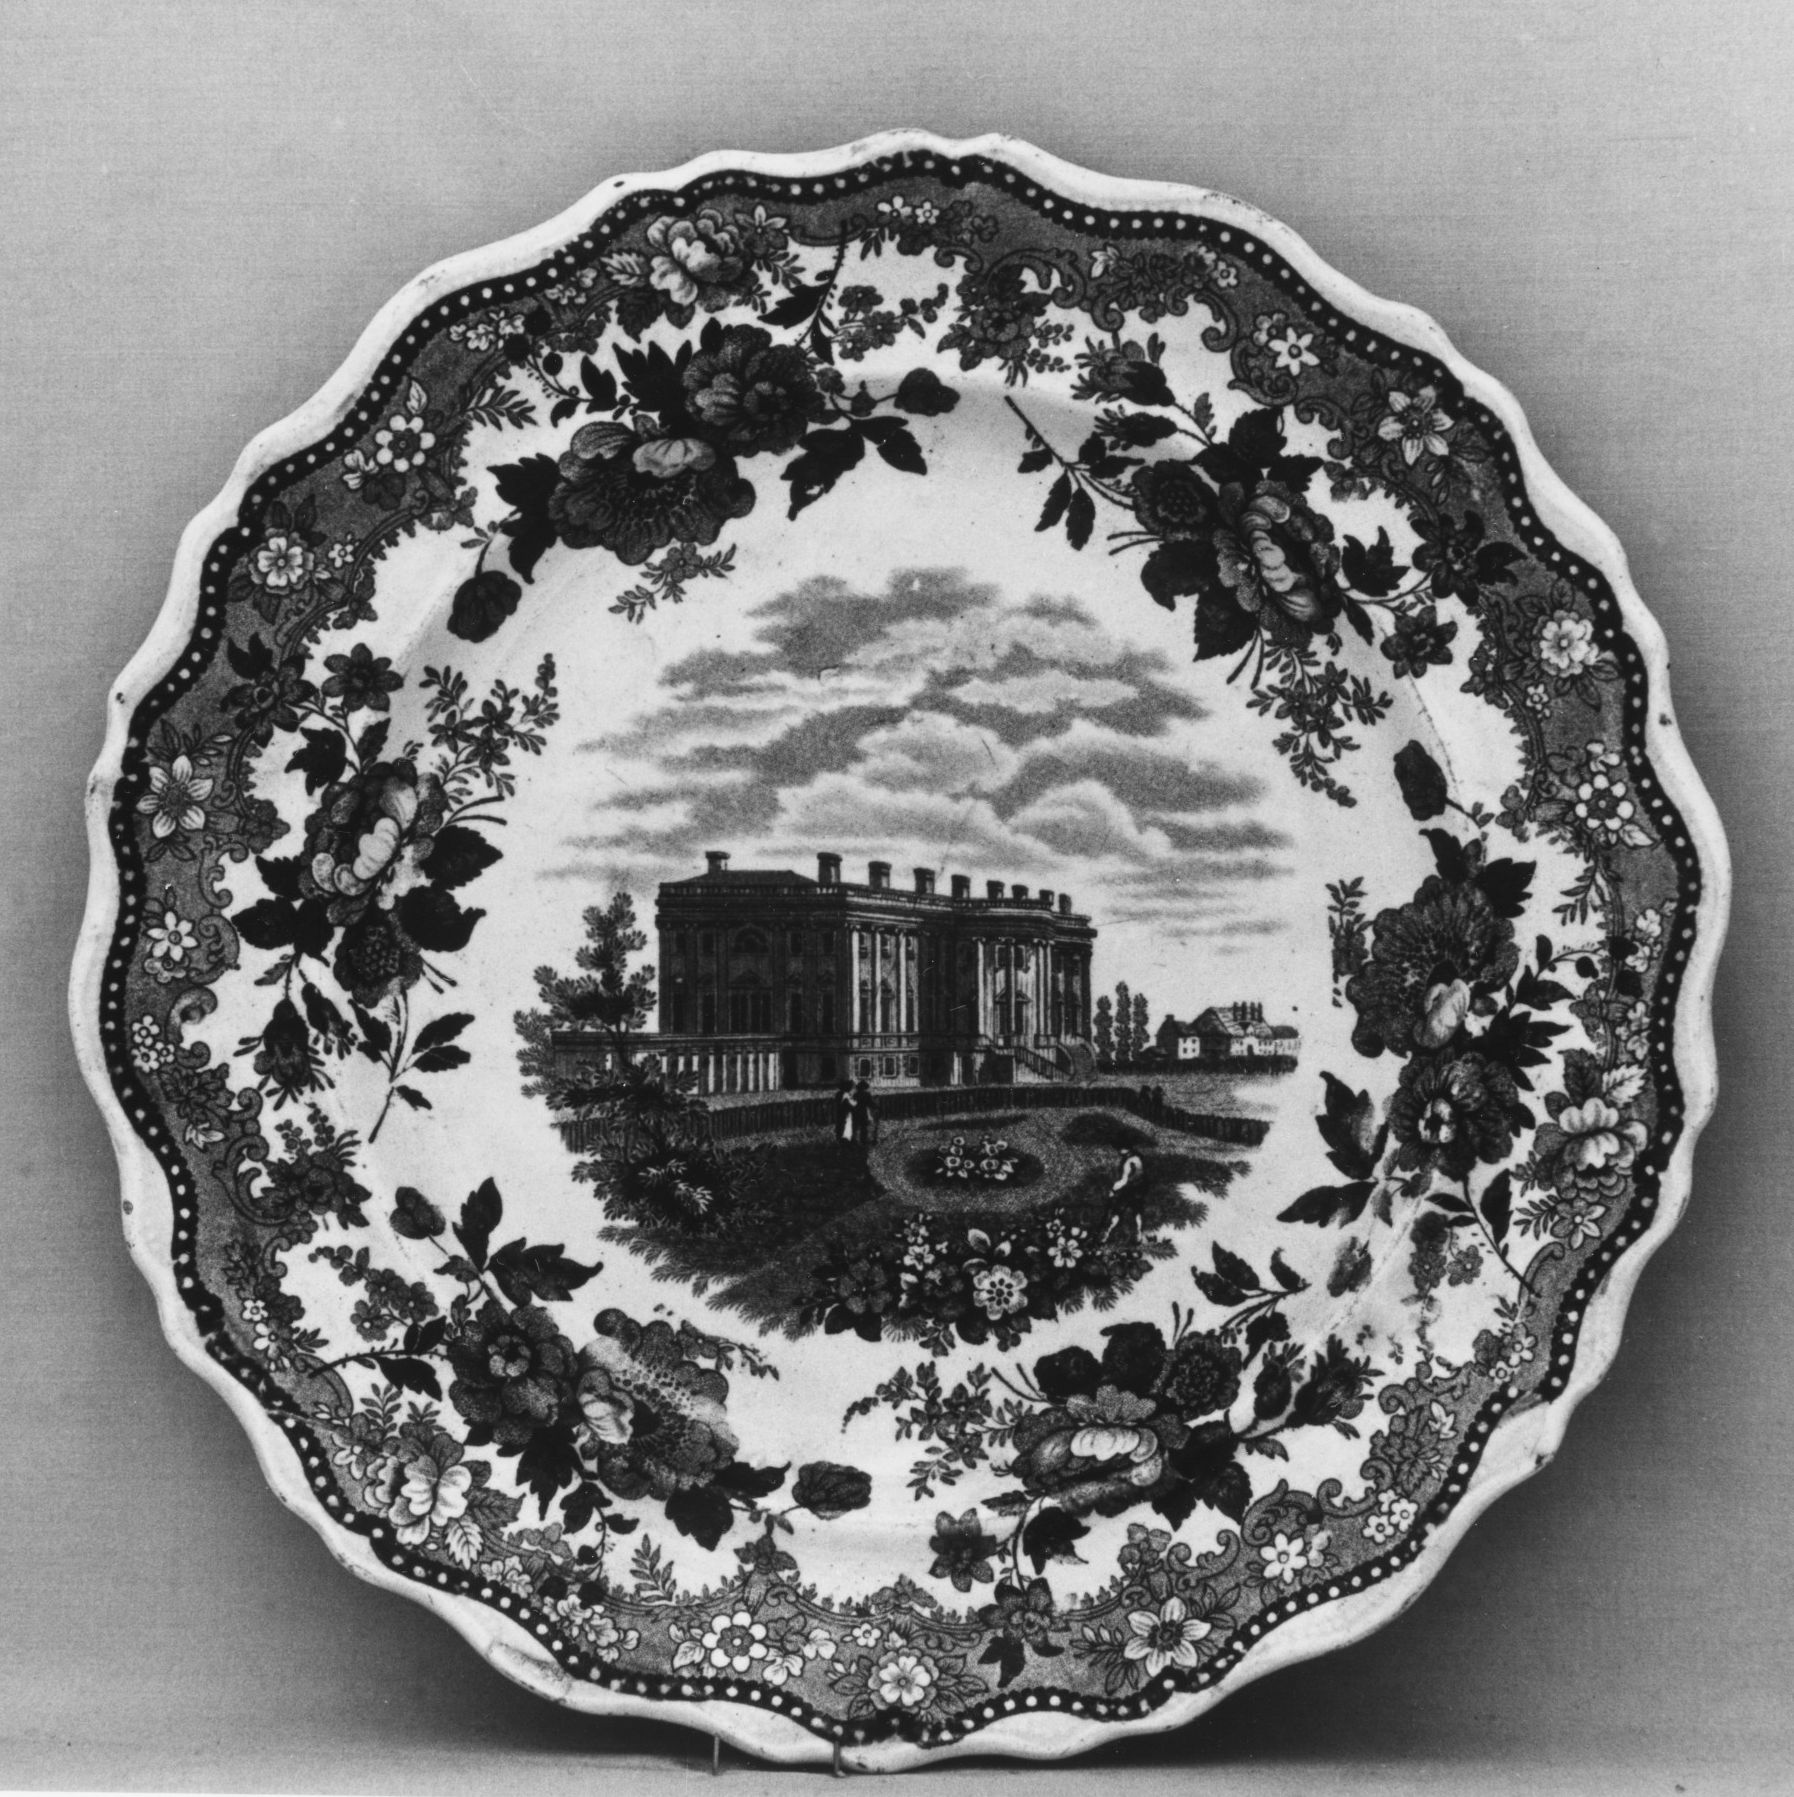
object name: plate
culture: british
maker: job & john jackson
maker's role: maker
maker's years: 1831-1835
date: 1831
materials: earthenware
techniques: transfer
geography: england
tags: buildings,flowers